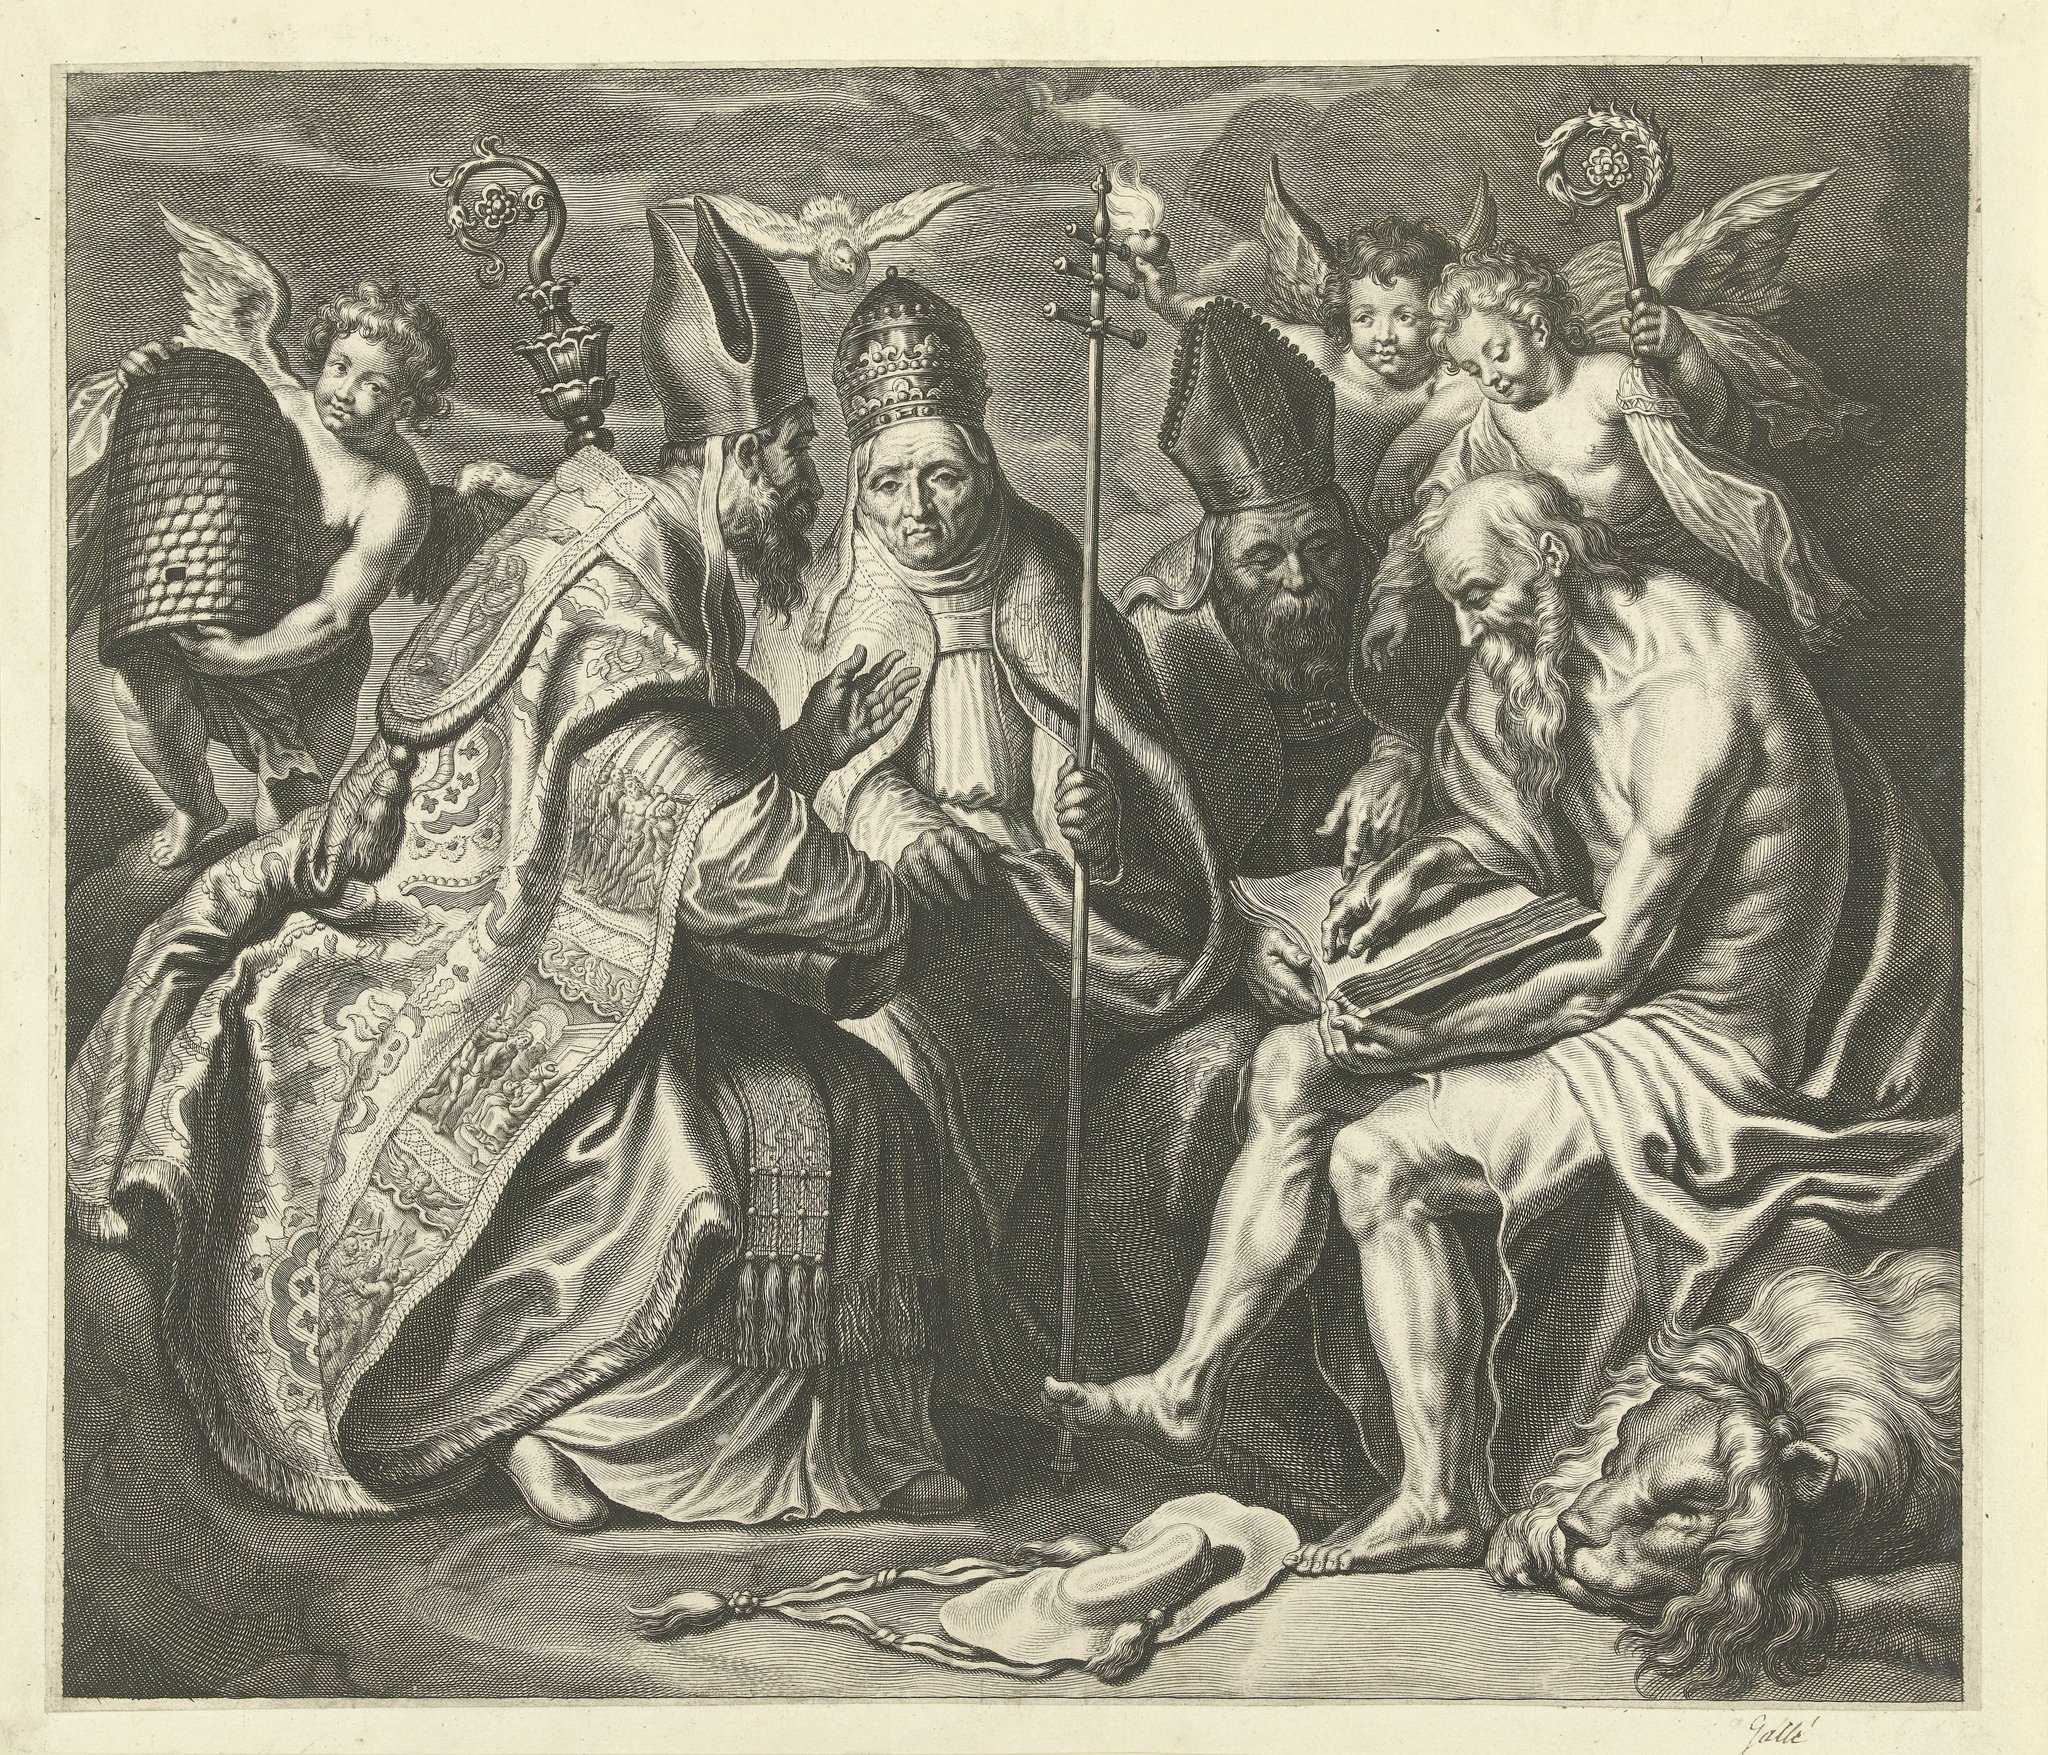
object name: print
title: De vier kerkvaders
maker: cornelis galle (i)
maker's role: print maker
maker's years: 1576-1650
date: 1600-1642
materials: paper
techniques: engraving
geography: antwerp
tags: the four latin (western) fathers of the church together: ambrose (usually as bishop), jerome (usually as cardinal), augustine (usually as bishop), gregory the great (usually as pope) (+ angel(s))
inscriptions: collector's mark: Lugt 240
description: De vier Latijnse kerkvaders zitten in de hemel bij elkaar en bespreken een bijbeltekst. Rechts Hieronymus met de leeuw. Ernaast Augustinus met het brandend hart, in het midden links paus Gregorius en geheel links Ambrosius, te herkennen aan zijn attribuut de bijenkorf.